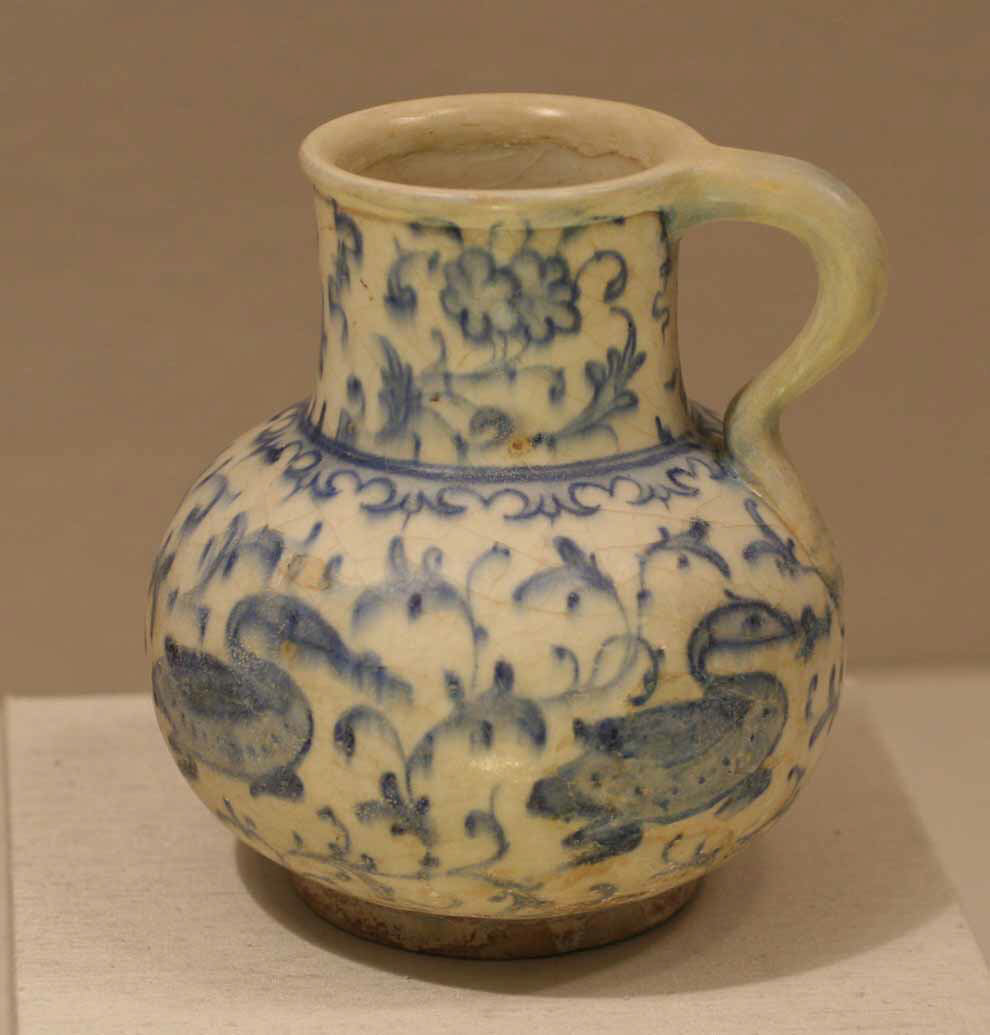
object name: ewer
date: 1467-1500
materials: glaze, stonepaste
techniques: painting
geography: iran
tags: ducks